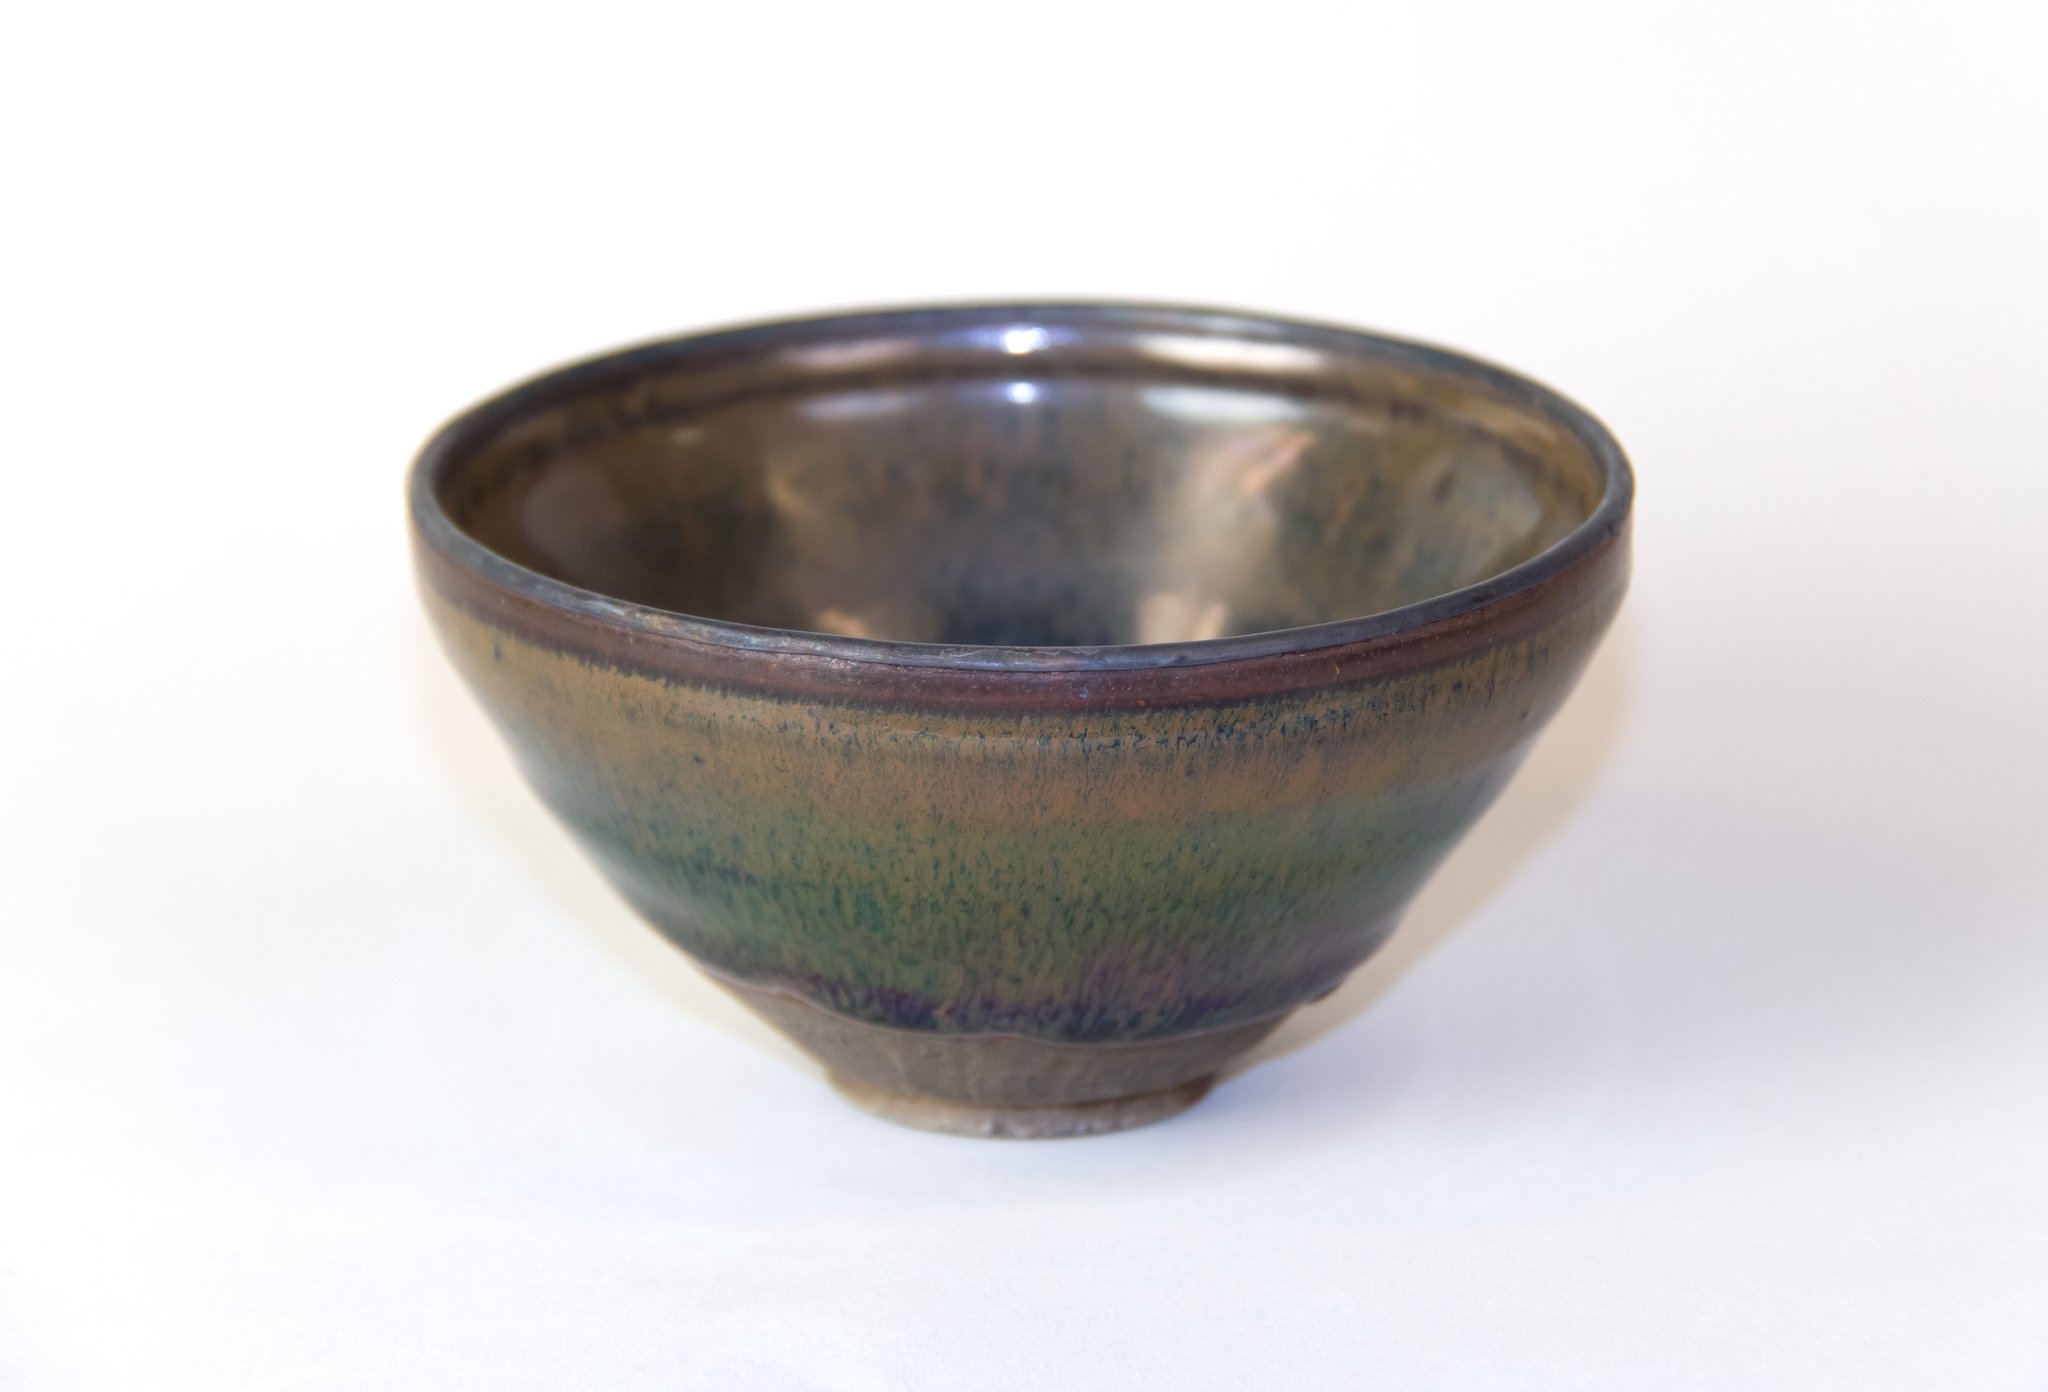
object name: bowl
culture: chinese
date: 960-1279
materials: pottery